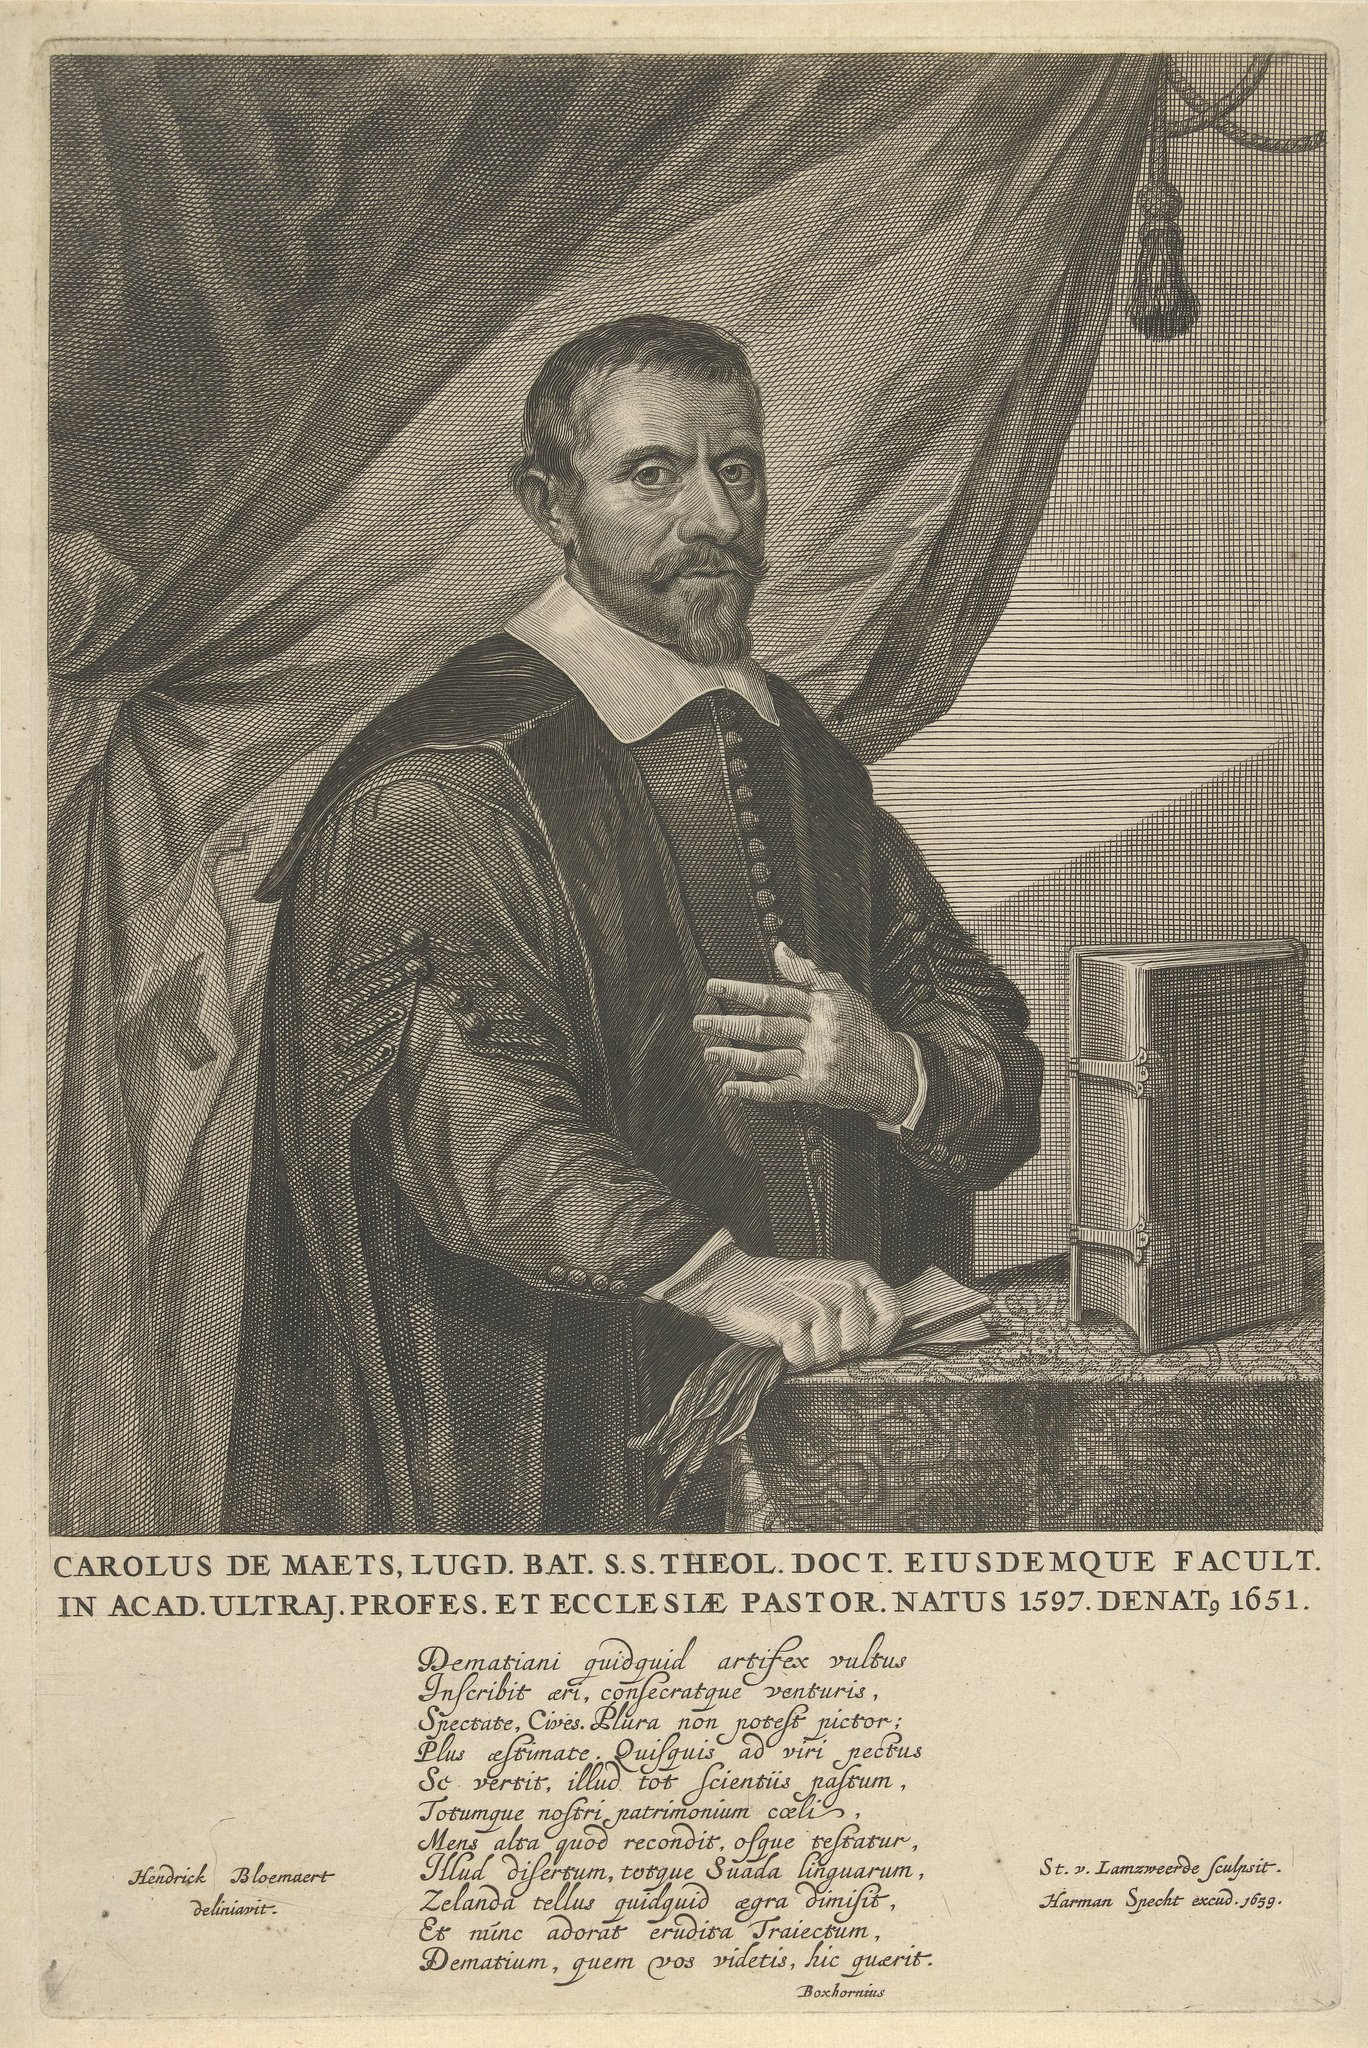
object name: print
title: Portret van Carolus de Maets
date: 1659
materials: paper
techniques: engraving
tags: theoloog, professor, carolus de maets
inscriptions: collector's mark: Lugt 2228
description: Portret ten halven lijve naar rechts van Carolus de Maets, hoogleraar in de theologie te Utrecht, blootshoofds. Op de tafel voor hem staat een bijbel. In de marge staan de naam, titels, geboorte- en sterfjaren van de geportretteerde, gevolgd door een elfregelig Latijns vers.